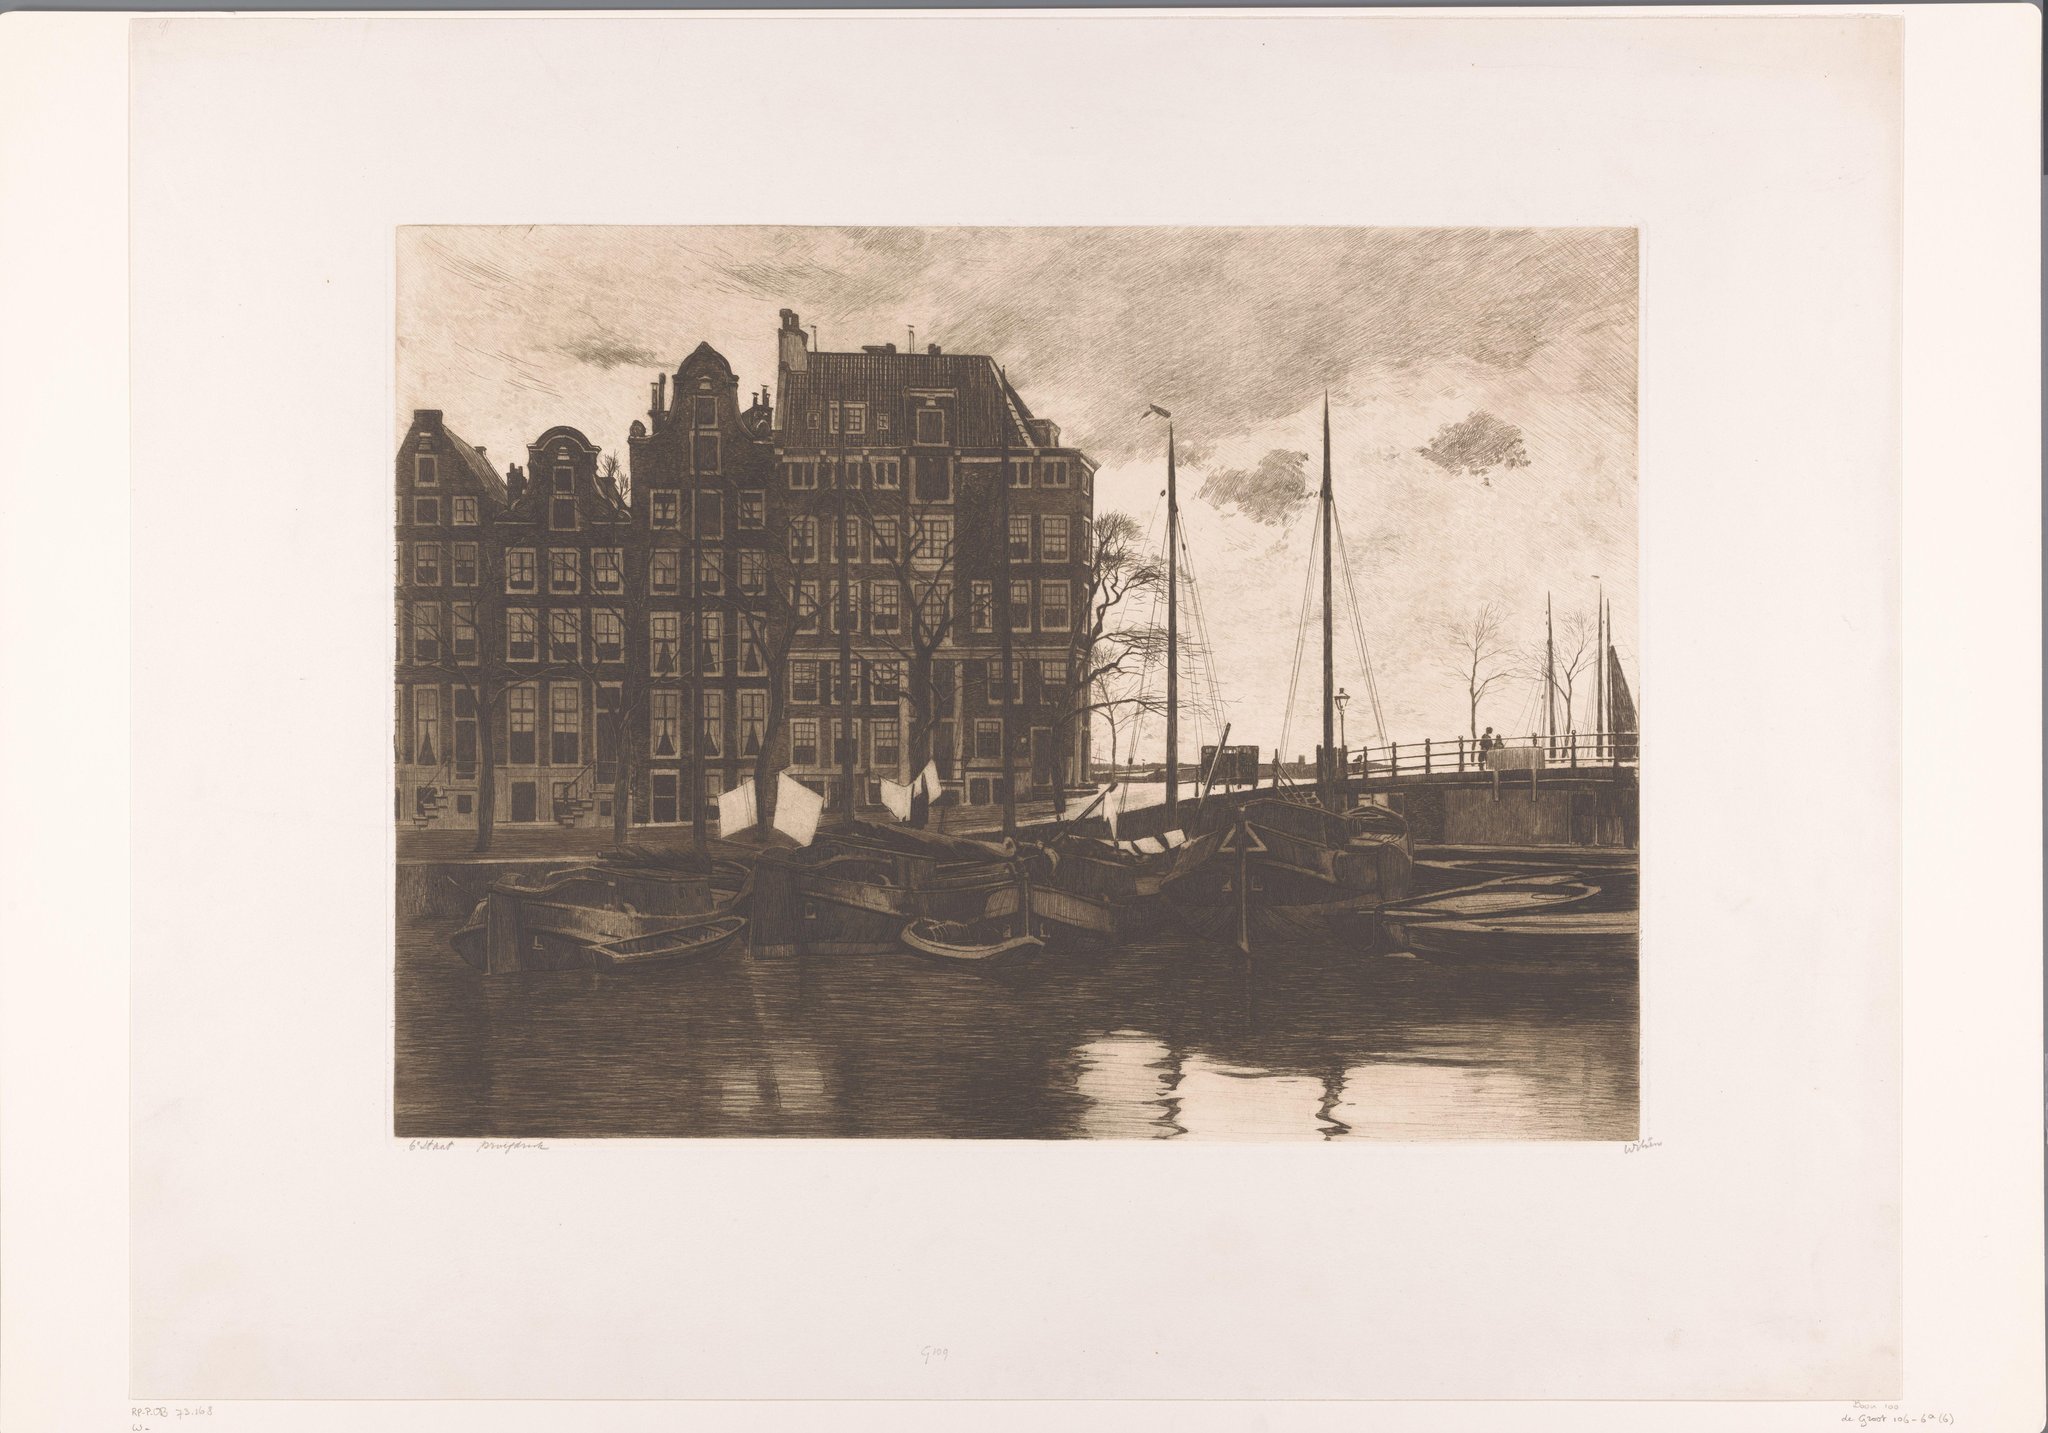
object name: print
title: Schepen op een gracht in Amsterdam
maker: willem witsen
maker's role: draughtsman, painter, print maker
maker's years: 1860-1923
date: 1875-1923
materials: paper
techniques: aquatint, etching, intaglio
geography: netherlands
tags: sailing-ship, sailing-boat, canals, waters (in city), façade (of house or building), amsterdam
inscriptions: collector's mark: Lugt 2228